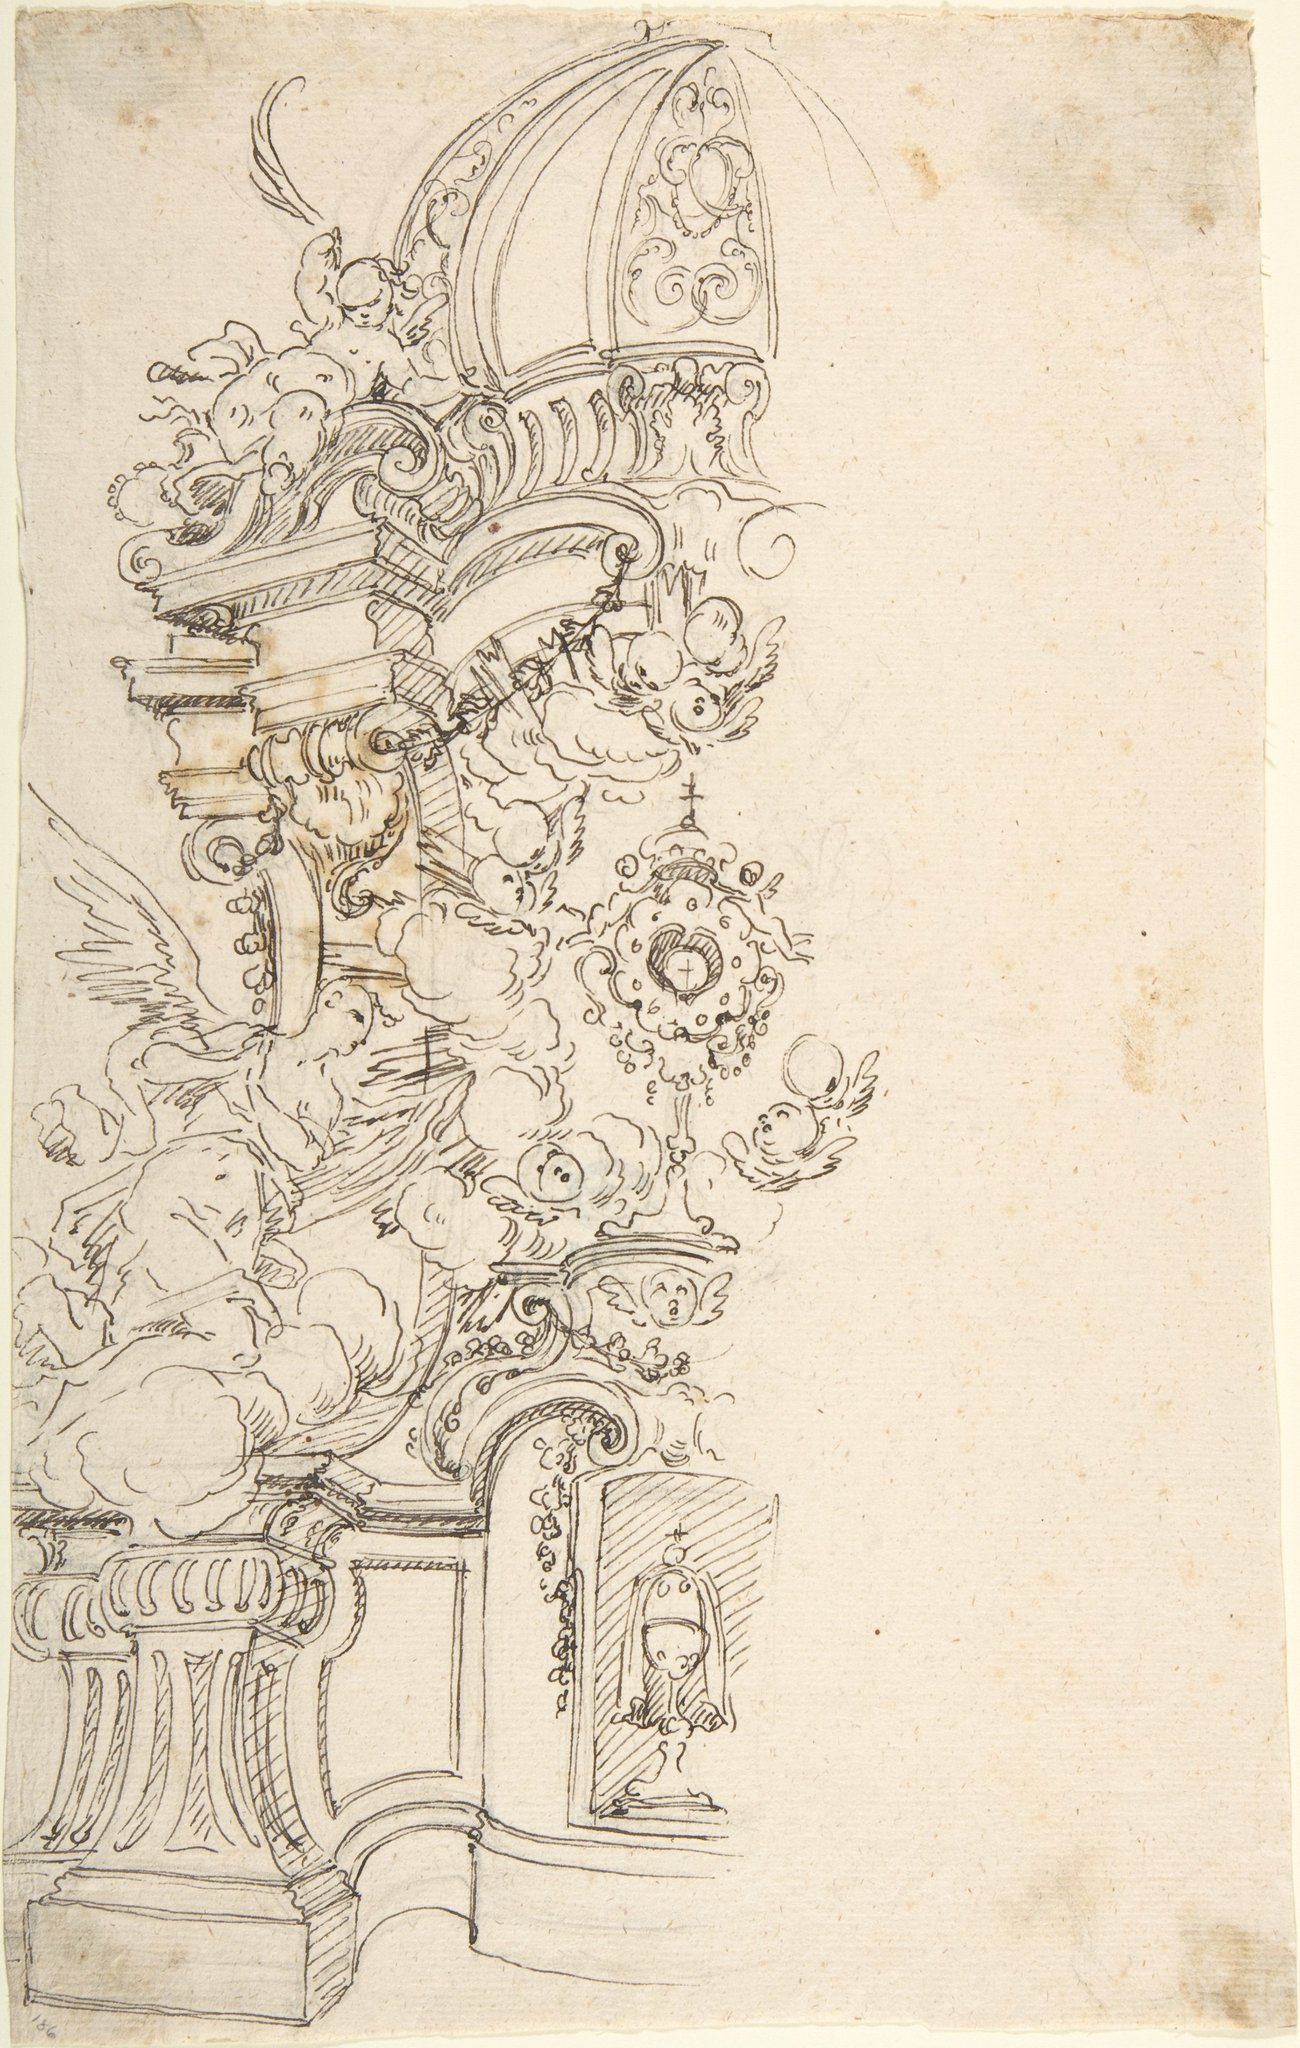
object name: drawing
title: Design for One Half of an Altar, with an Angel (of the Annunciation) at the left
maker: anonymous, italian, piedmontese, 18th century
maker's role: artist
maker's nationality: italian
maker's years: 1700-1800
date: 1700-1780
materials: ink, drawing material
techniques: pen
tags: altars,flowers,angels